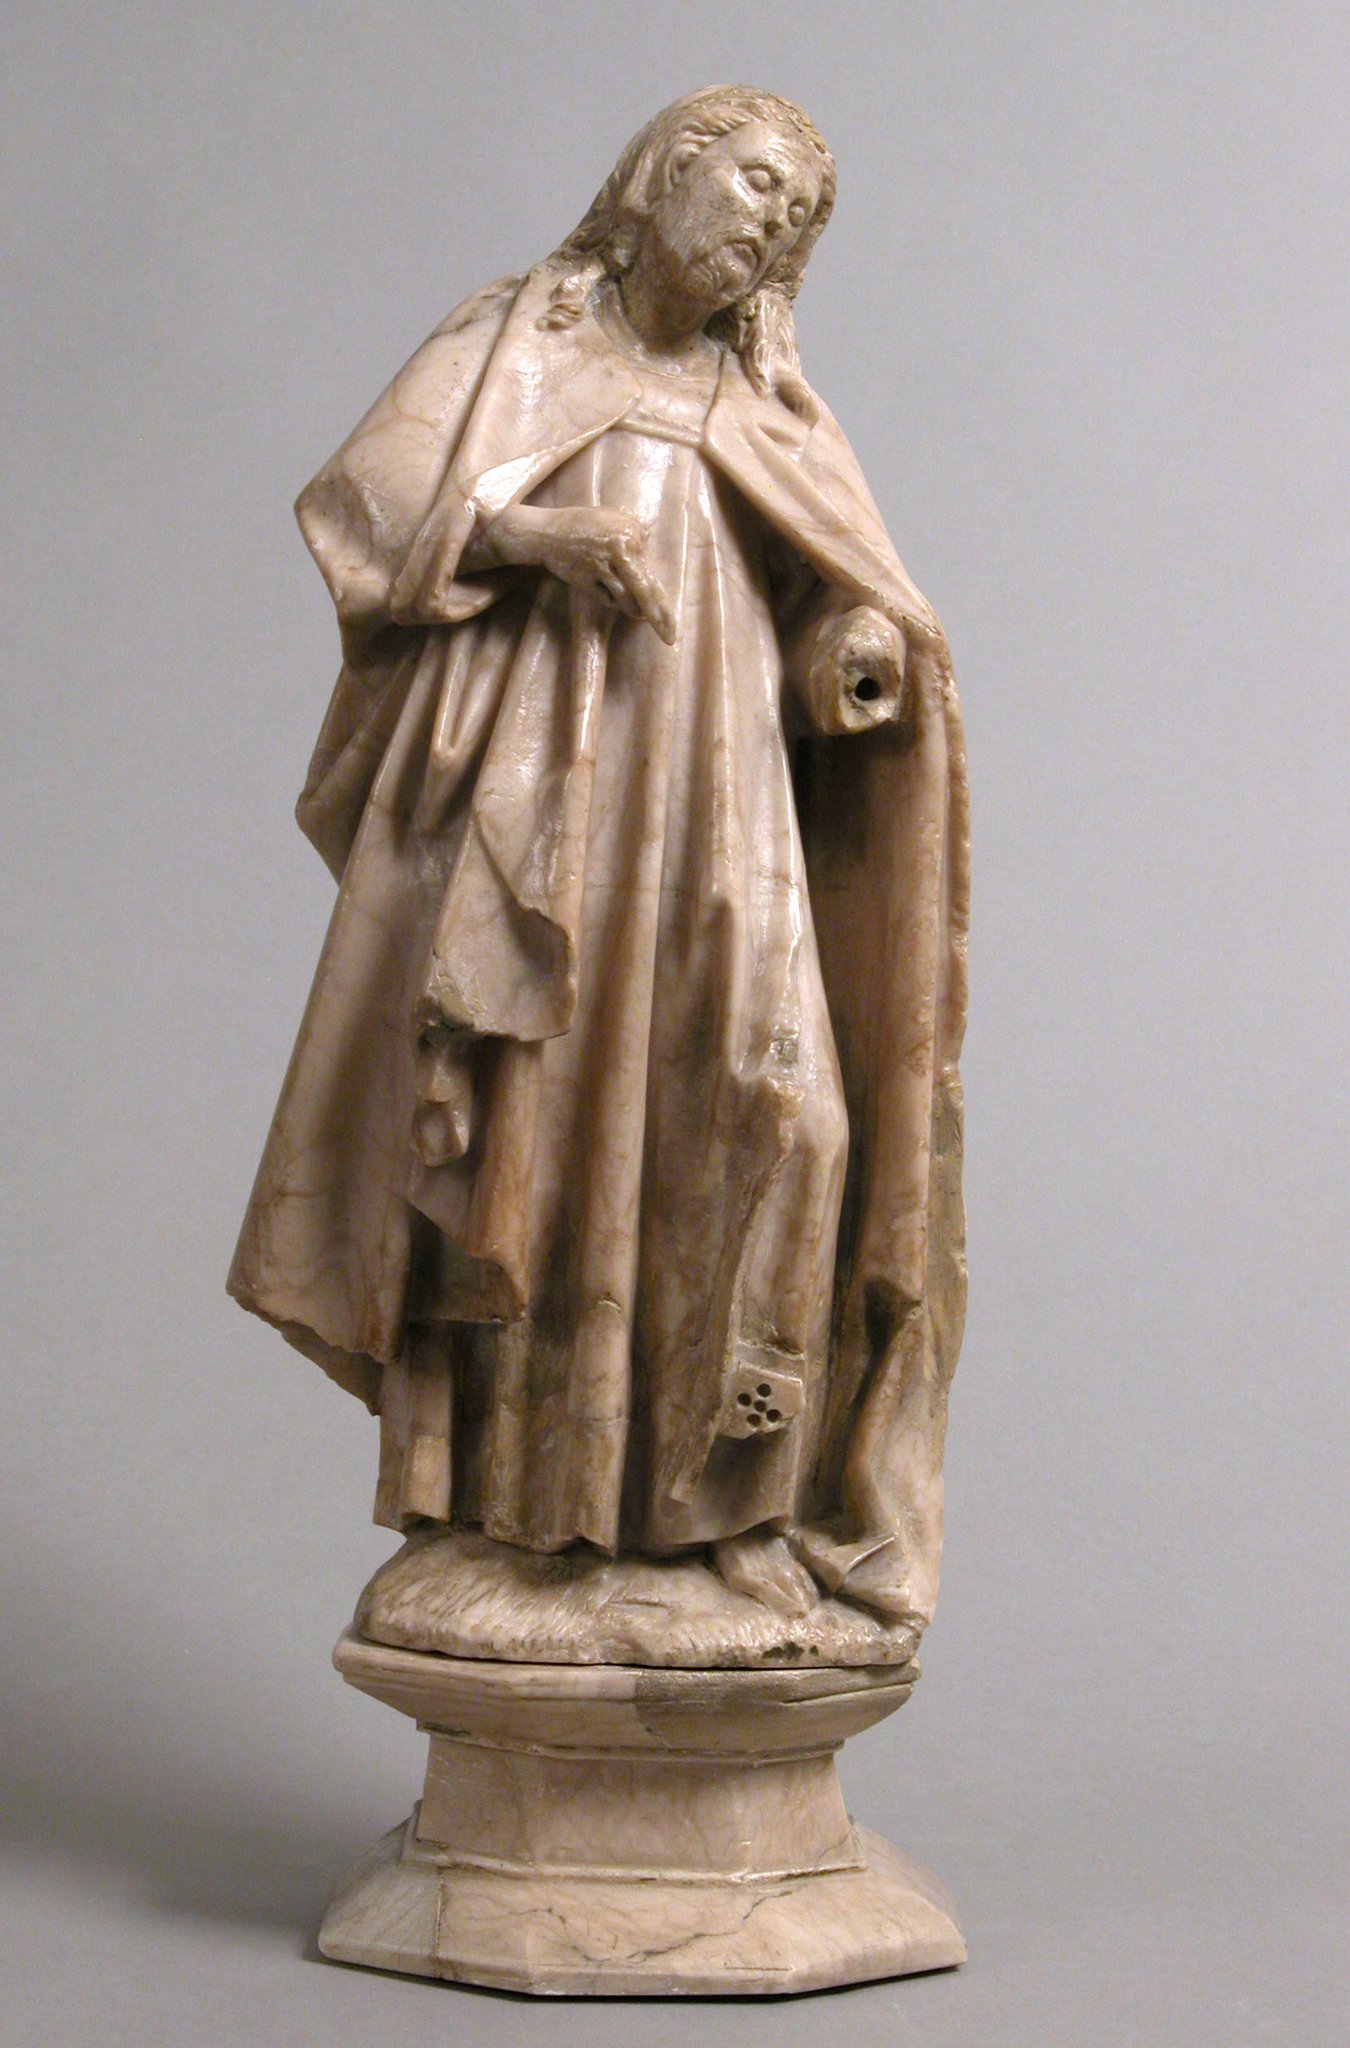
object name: statuette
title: Saint James the Less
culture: northeast french or south netherlandish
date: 1450-1460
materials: alabaster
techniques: polychromy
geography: france or netherlands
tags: apostles